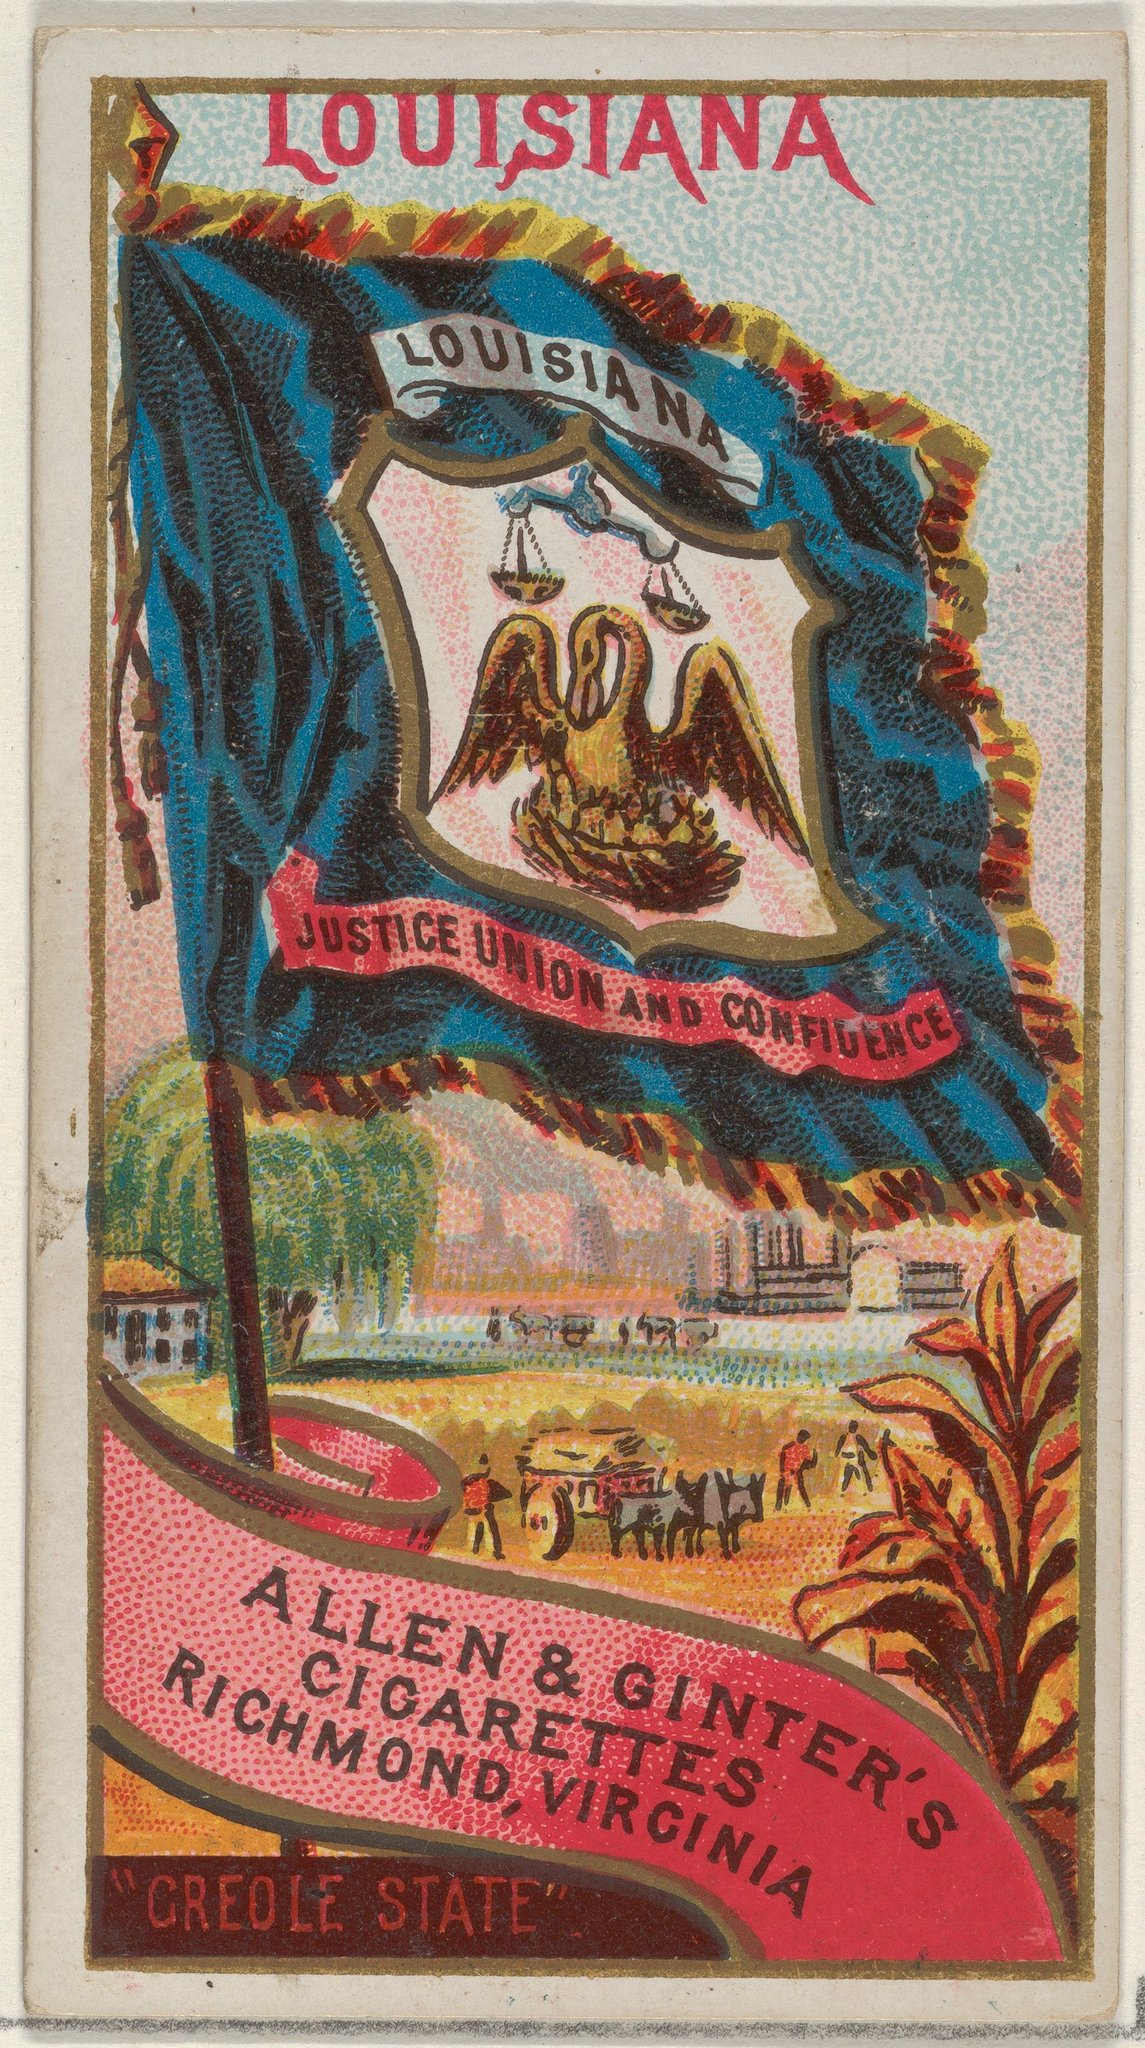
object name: print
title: Louisiana, from Flags of the States and Territories (N11) for Allen & Ginter Cigarettes Brands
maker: allen & ginter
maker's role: publisher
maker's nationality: american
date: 1888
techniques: color lithograph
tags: flags